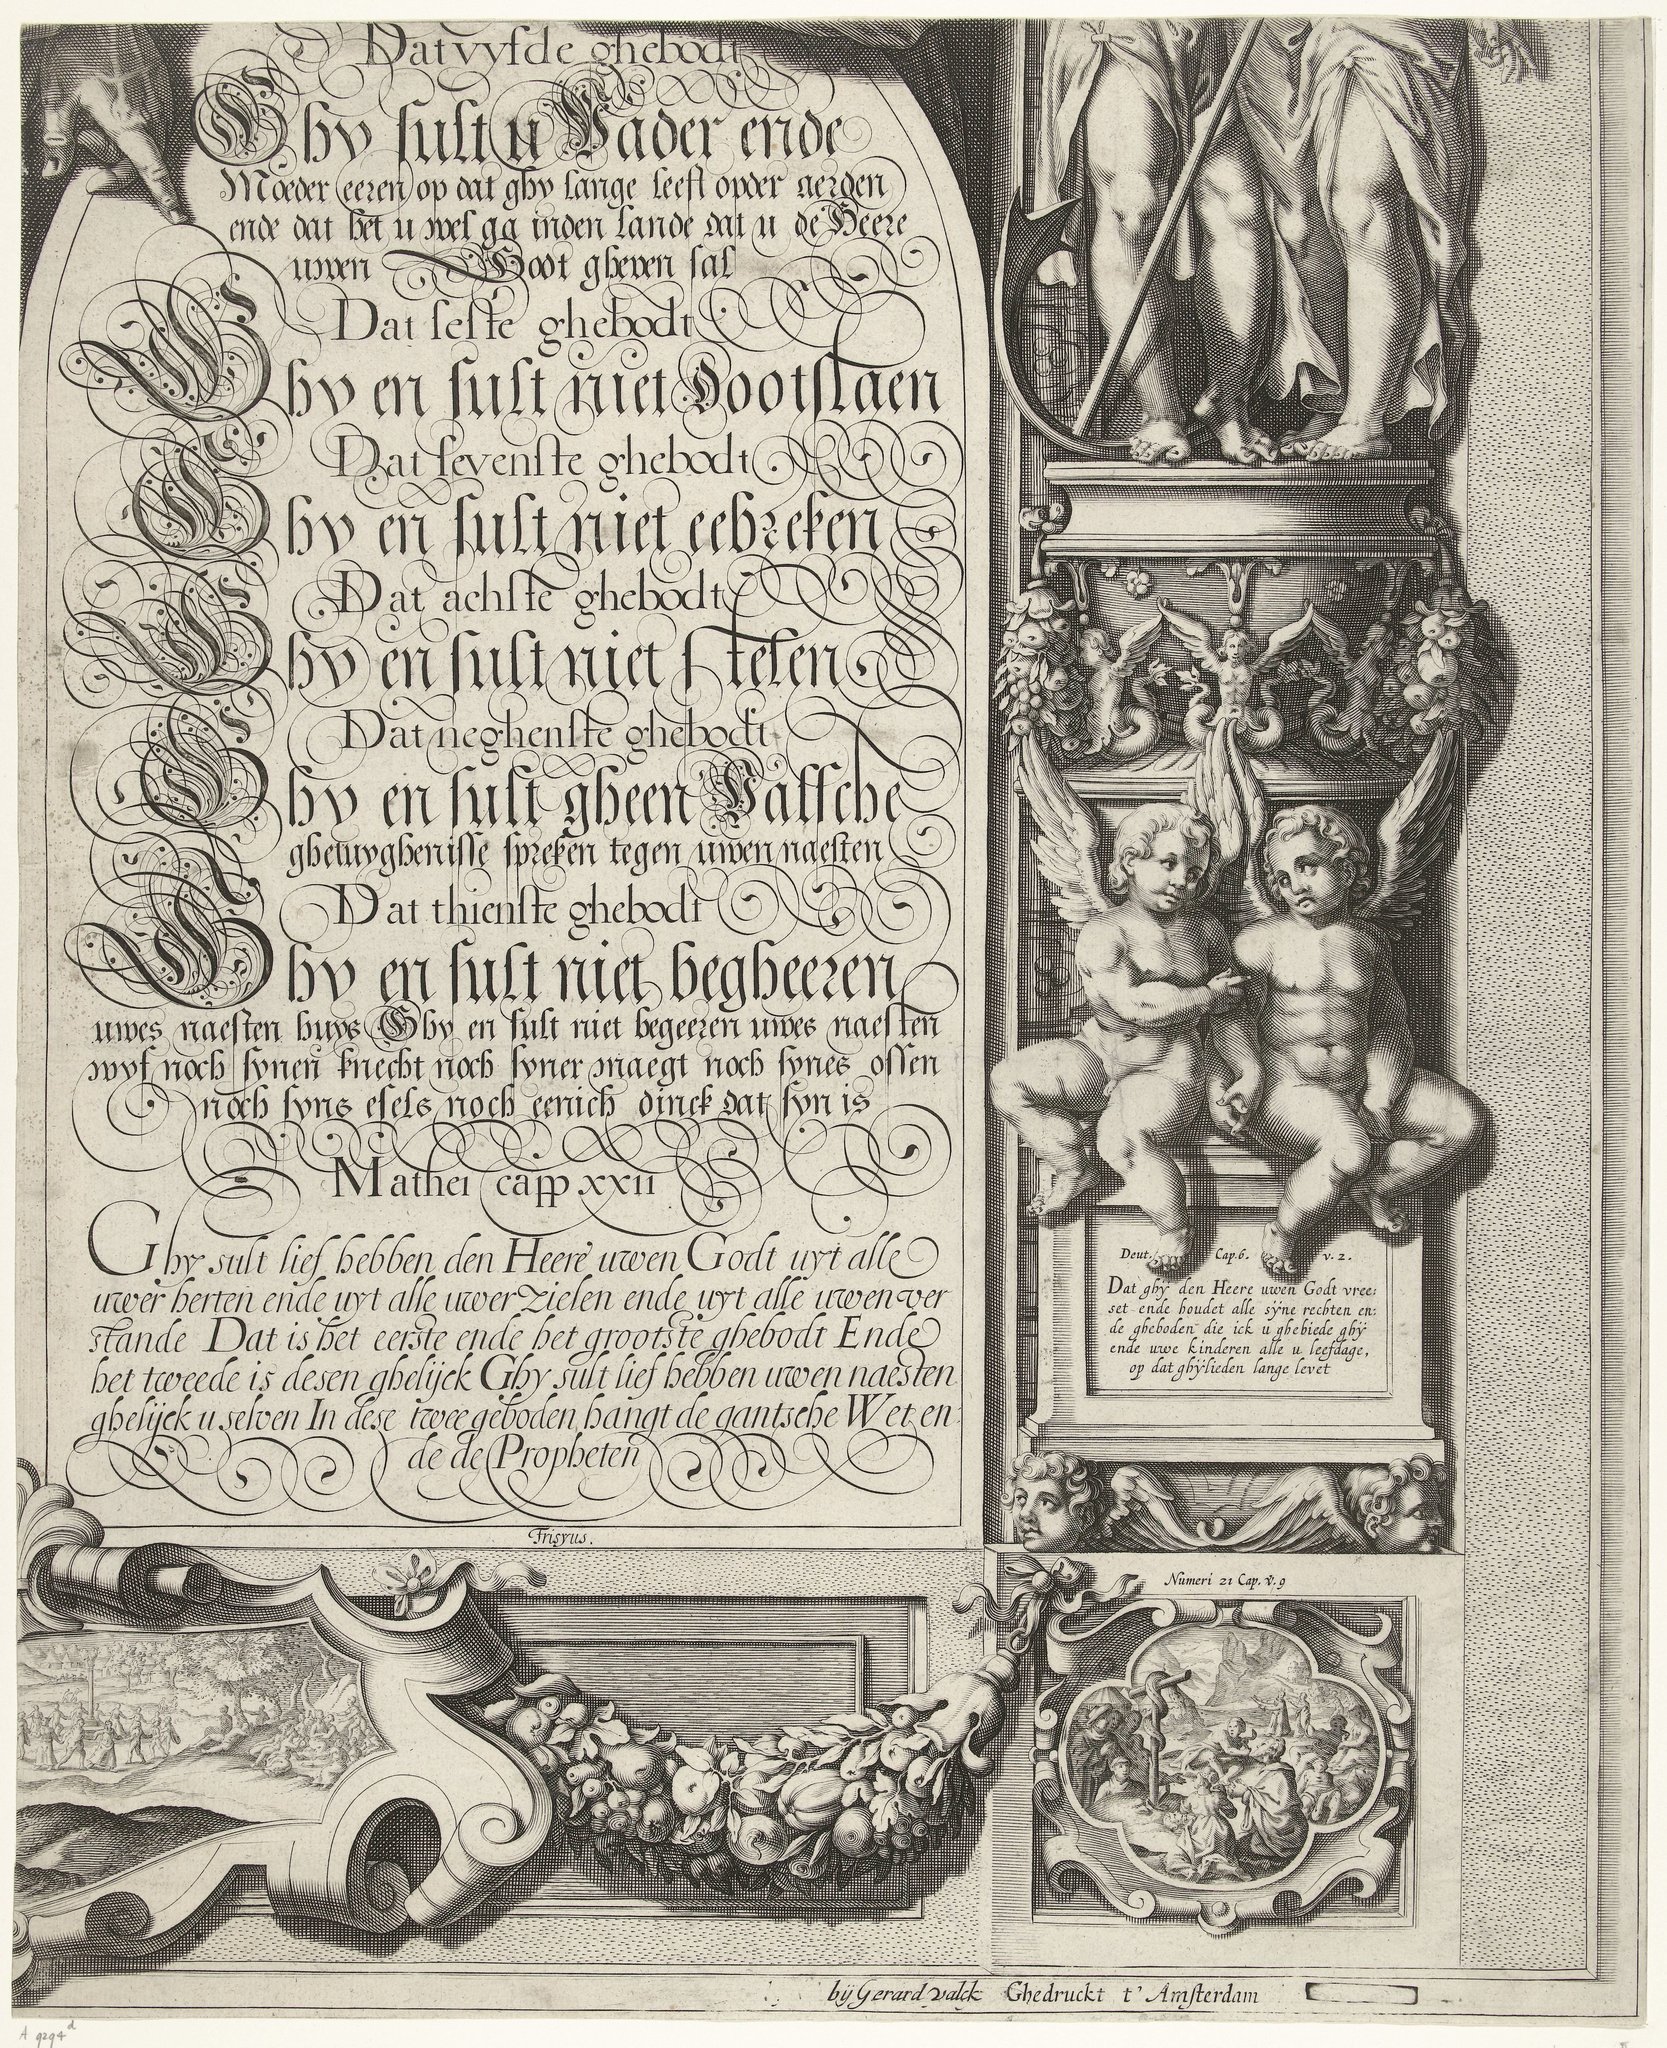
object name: print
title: Mozes en Aäron met de Tafelen der Wet (blad rechtsonder)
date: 1670-1726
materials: paper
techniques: engraving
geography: amsterdam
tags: aaron (not in biblical context); possible attributes: attributes of aaron: censer, dressed as high priest or bishop, ointment jar, rod or flowering wand, moses (not in biblical context); possible attributes: rays of light or horns on his head, rod, tables of the law, the ten commandments represented together on stone tablets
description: Het vijfde tot en met het tiende gebod van de Tafelen der Wet. Rechtsonder een cartouche met de voorstelling van Mozes en de koperen slang. Daarboven twee putti zittend op een decoratief element met daarop een christelijke tekst.